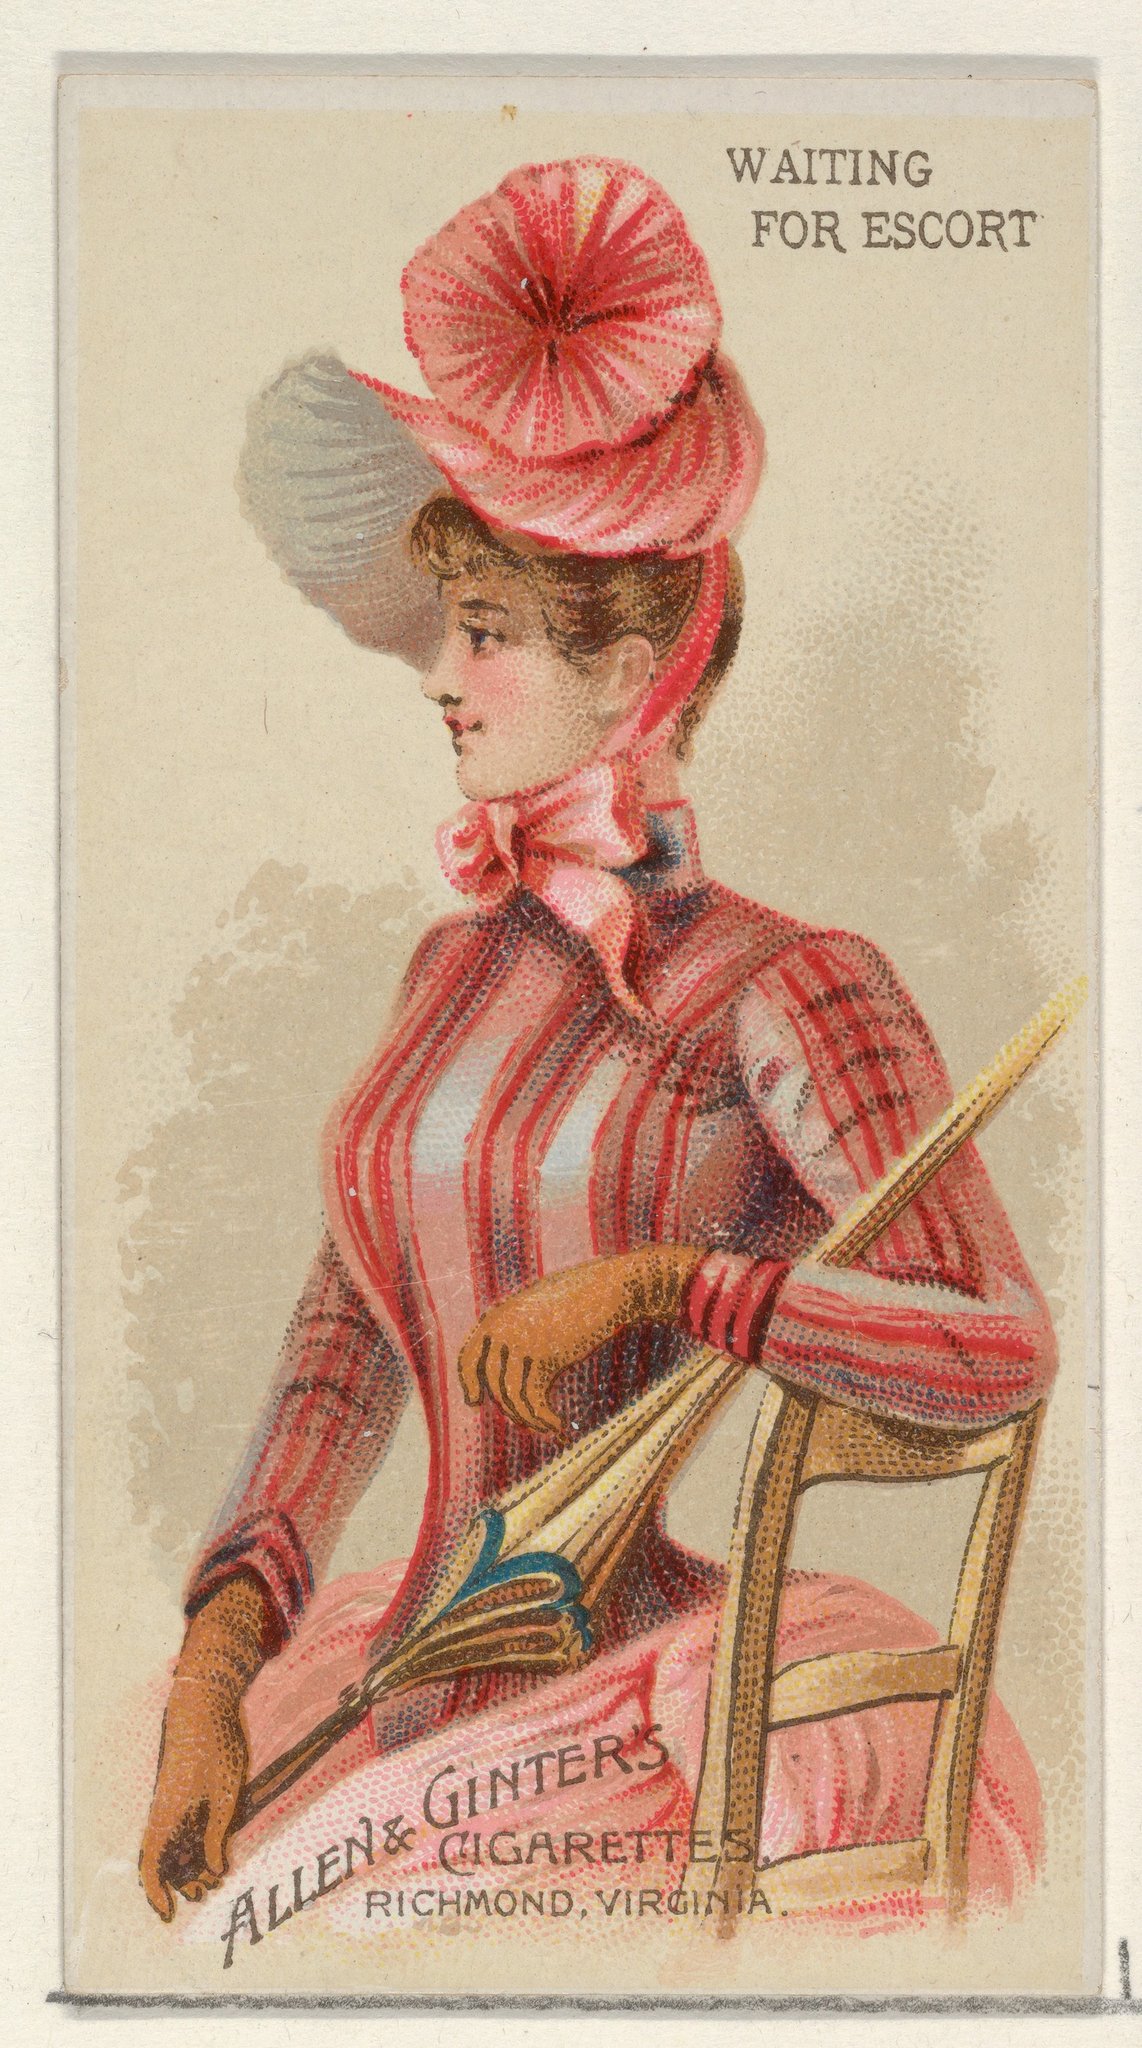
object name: print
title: Wait for Escort, from the Parasol Drills series (N18) for Allen & Ginter Cigarettes Brands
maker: allen & ginter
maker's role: publisher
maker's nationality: american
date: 1888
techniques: color lithograph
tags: women